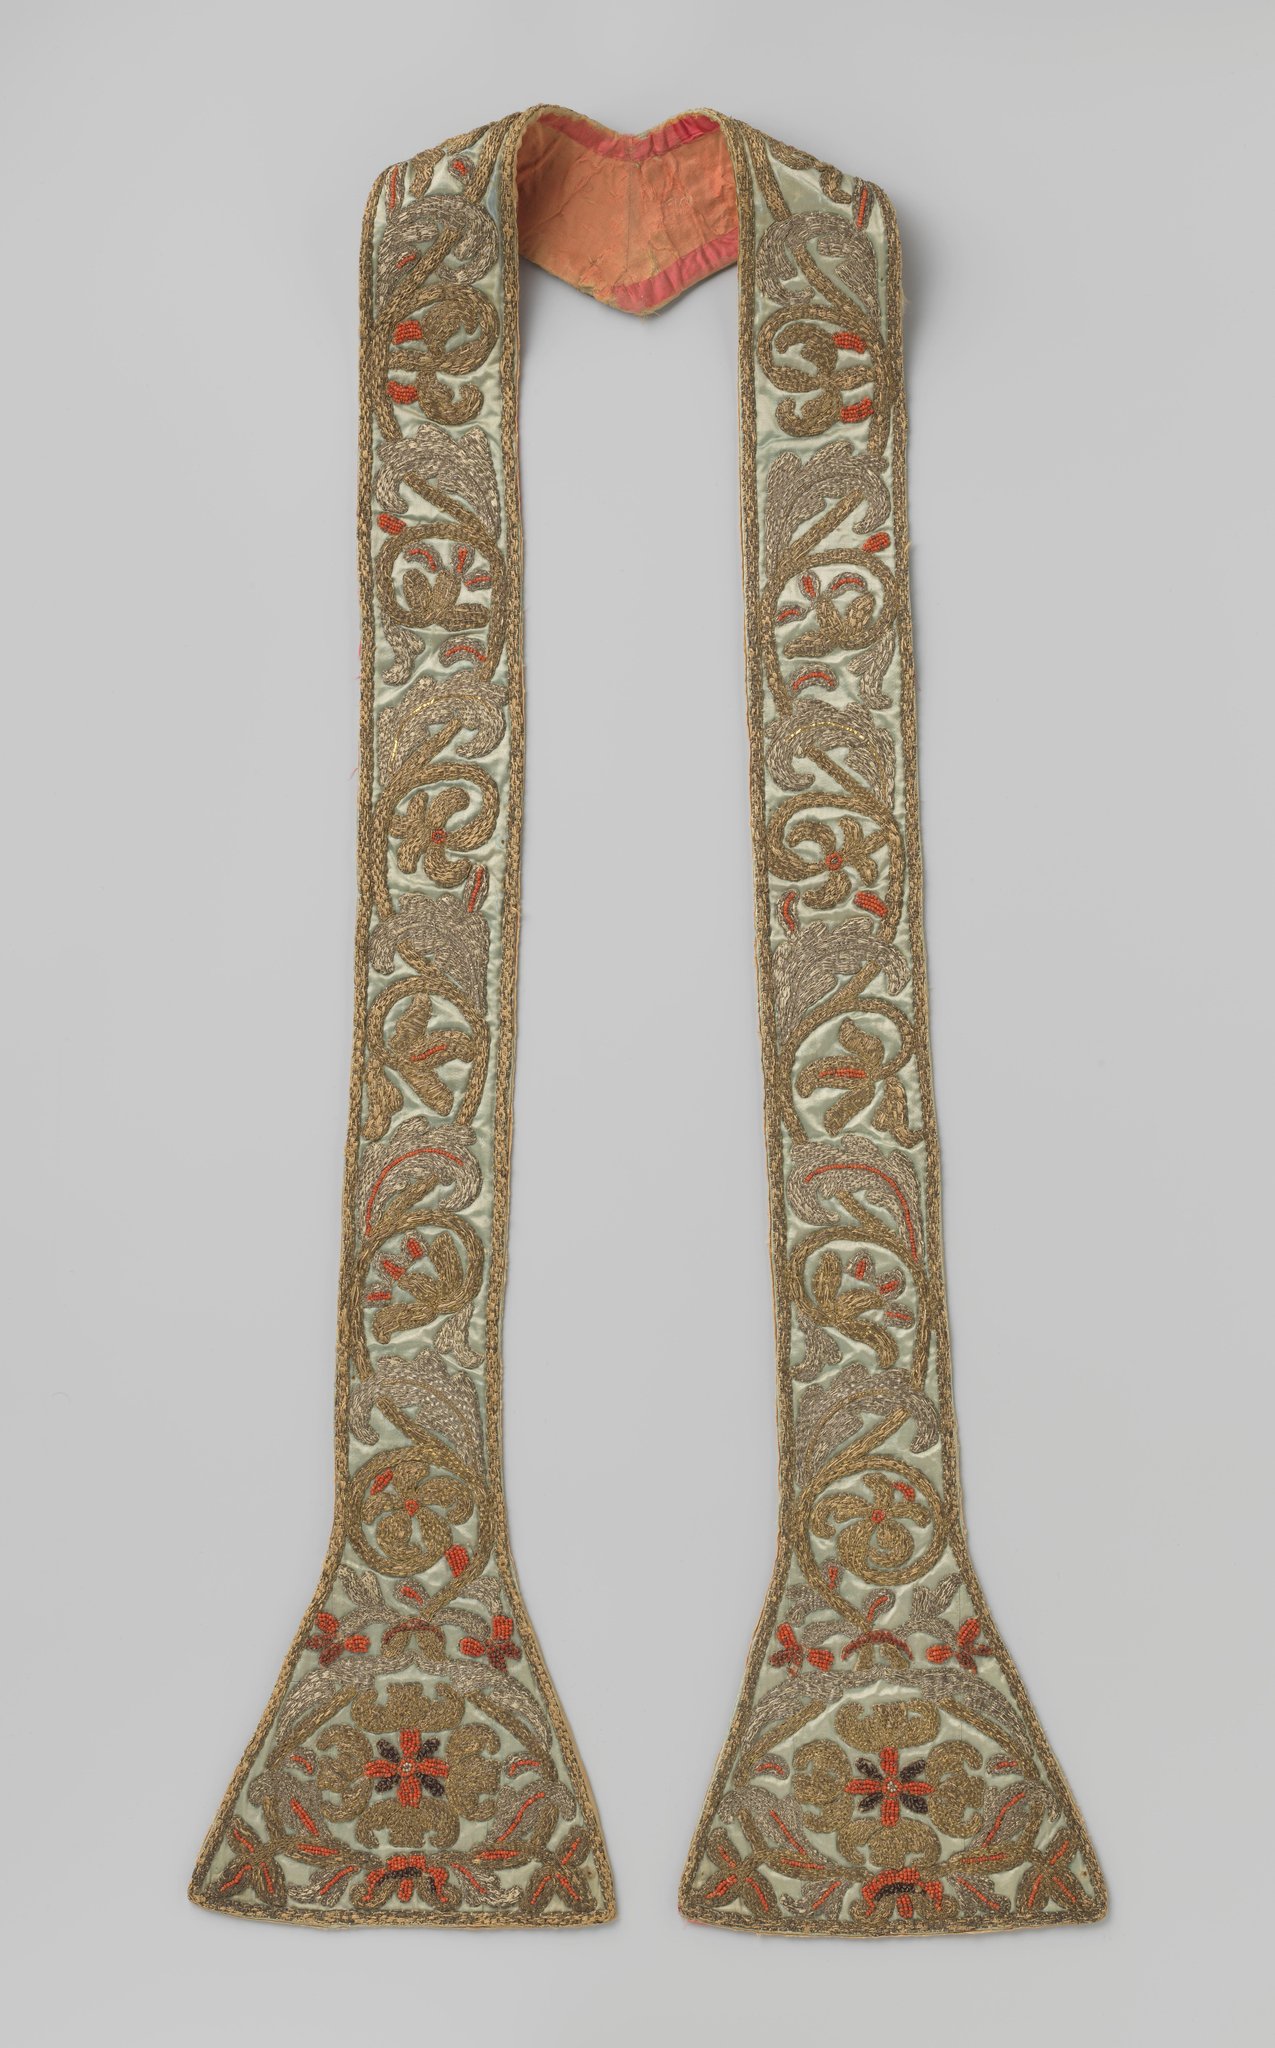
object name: stole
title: Stola met borduurwerk van goud- en zilverdraad, bloedkoralen, granaten en parels.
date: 1675-1700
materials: gemstone, gold thread, paste, pearl, coral, thread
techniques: embroidered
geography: italy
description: Stola met borduurwerk van goud- en zilverdraad, bloedkoralen, granaten en parels. De stola heeft gaffelvormige uiteinden. Het borduurwerk heeft een lopend rankenpatroon eindigend in gouden bloemen met zilveren bladen. De bloemharten zijn gevuld met koralen, granaten, parels en een enkele strasdiamant. De stola hoort bij zes kerkelijke borduurwerken met invnrs. BK-1966-54-A t/m BK-1966-54-F.